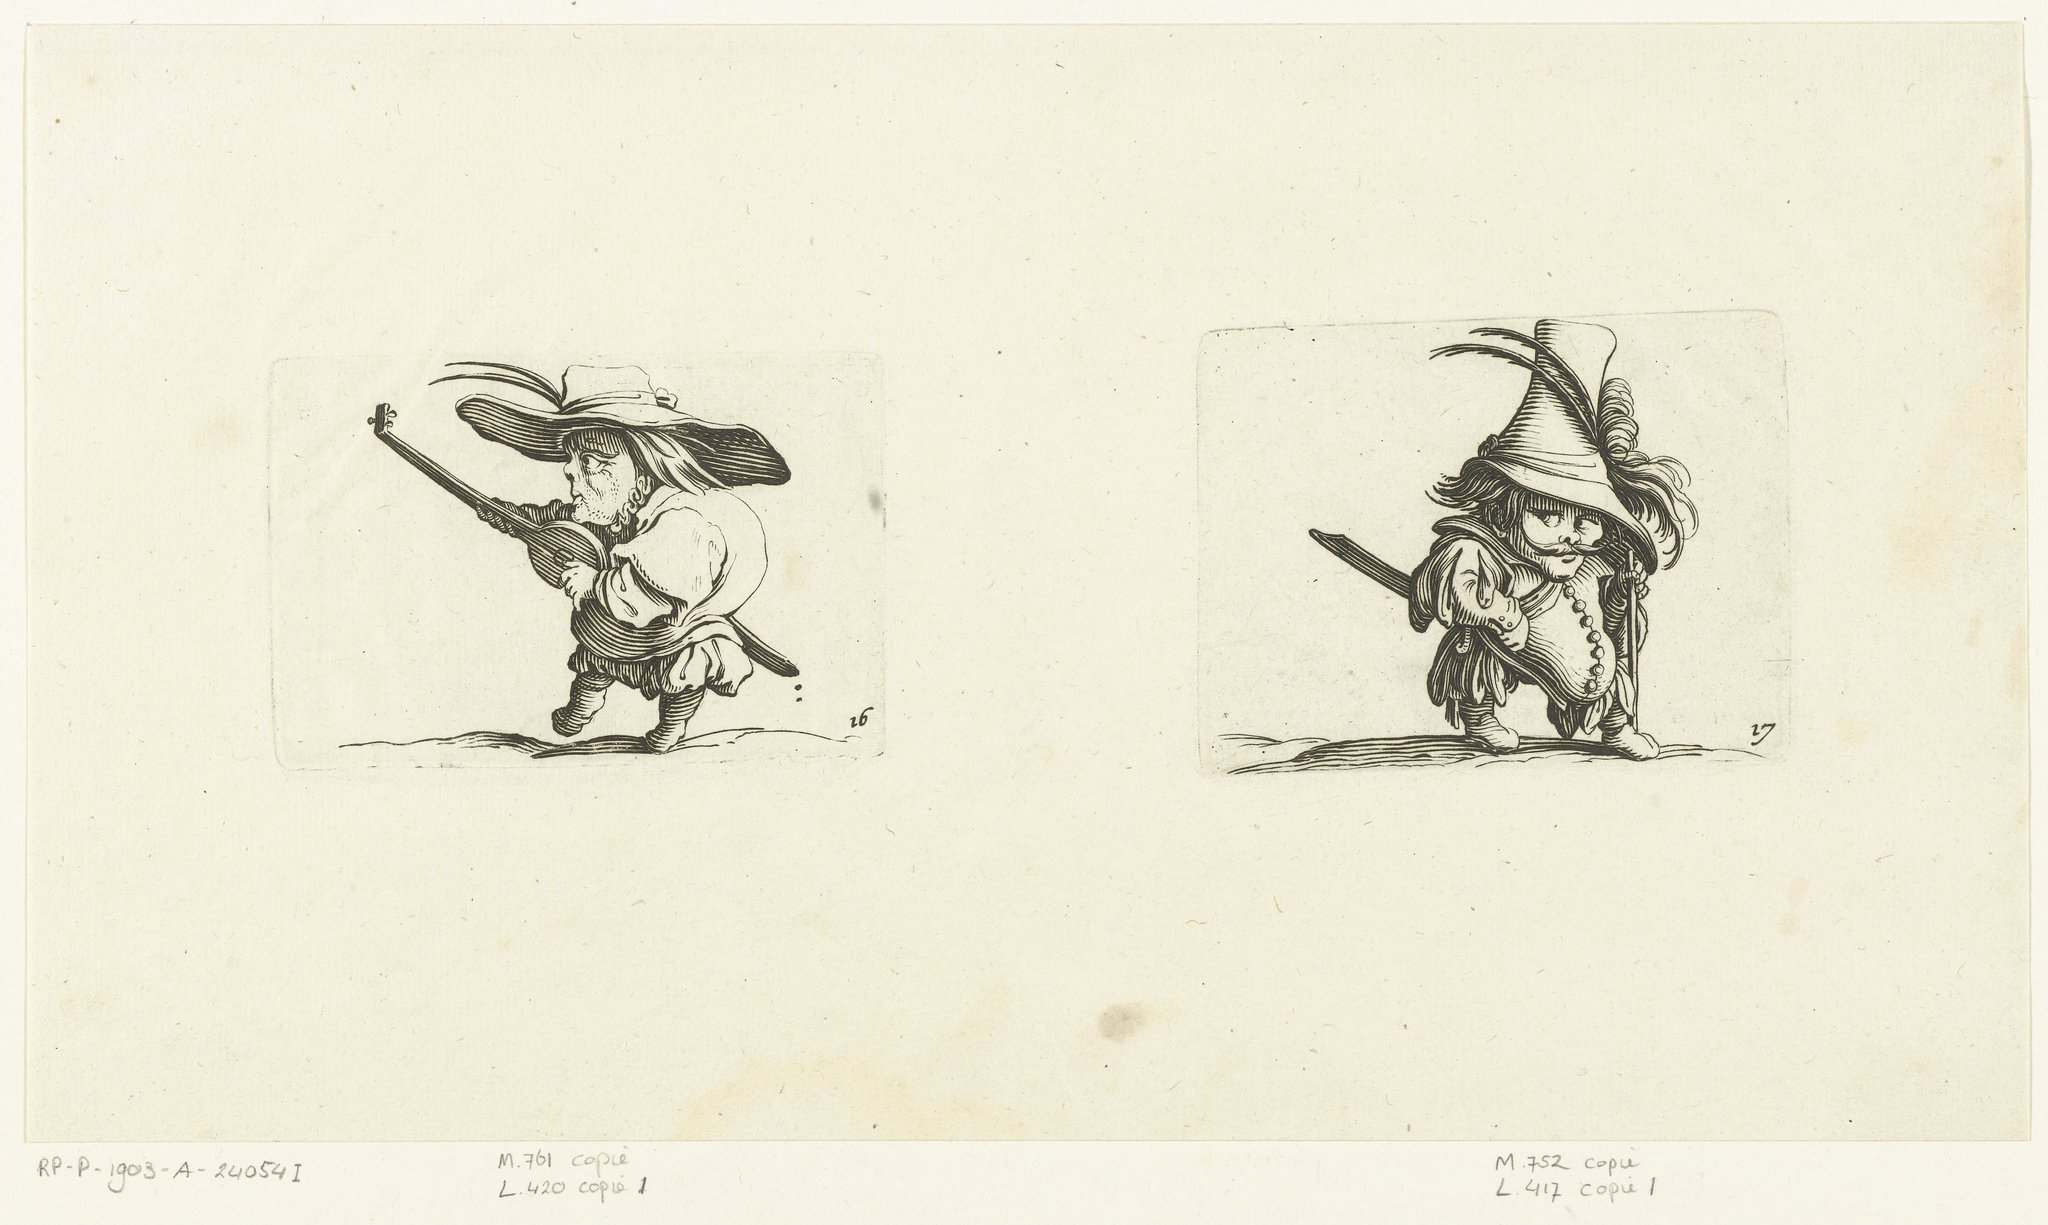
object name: print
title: Dwerg met luit en zwaard; Dwerg met zwaard en wandelstok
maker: abraham bosse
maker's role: draughtsman, print maker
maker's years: 1602-1676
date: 1621-1676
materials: paper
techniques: engraving, etching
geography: paris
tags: little people, walking-stick, staff, hacking and thrusting weapons: sword, hunchback, one person playing string instrument (plucked), lute, and special forms of lute, e.g.: theorbo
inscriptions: collector's mark: Lugt 2228a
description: Links: kleine mens (karikatuur), op de linkerzijde gezien, met een gebochelde rug, een luit bespelend, een hoed met twee veren op het hoofd, een zwaard aan zijn rechterzijde. Rechts: kleine mens (karikatuur), op de rechterzijde gezien, met een hangende buik waarover een knopenrij loopt, een hoge hoed met veren op het hoofd, de rechterhand aan het gevest van zijn zwaard, een wandelstok in de linkerhand. Deze beide prenten, naast elkaar op 1 blad gedrukt, zijn onderdeel van een serie van 21 prenten (op 11 bladen gedrukt, dus m.u.v. de titelprent steeds 2 platen per blad) met groteske figuren; vrijwel al die figuren zijn karikaturen van kleine mensen, velen zijn gebocheld.